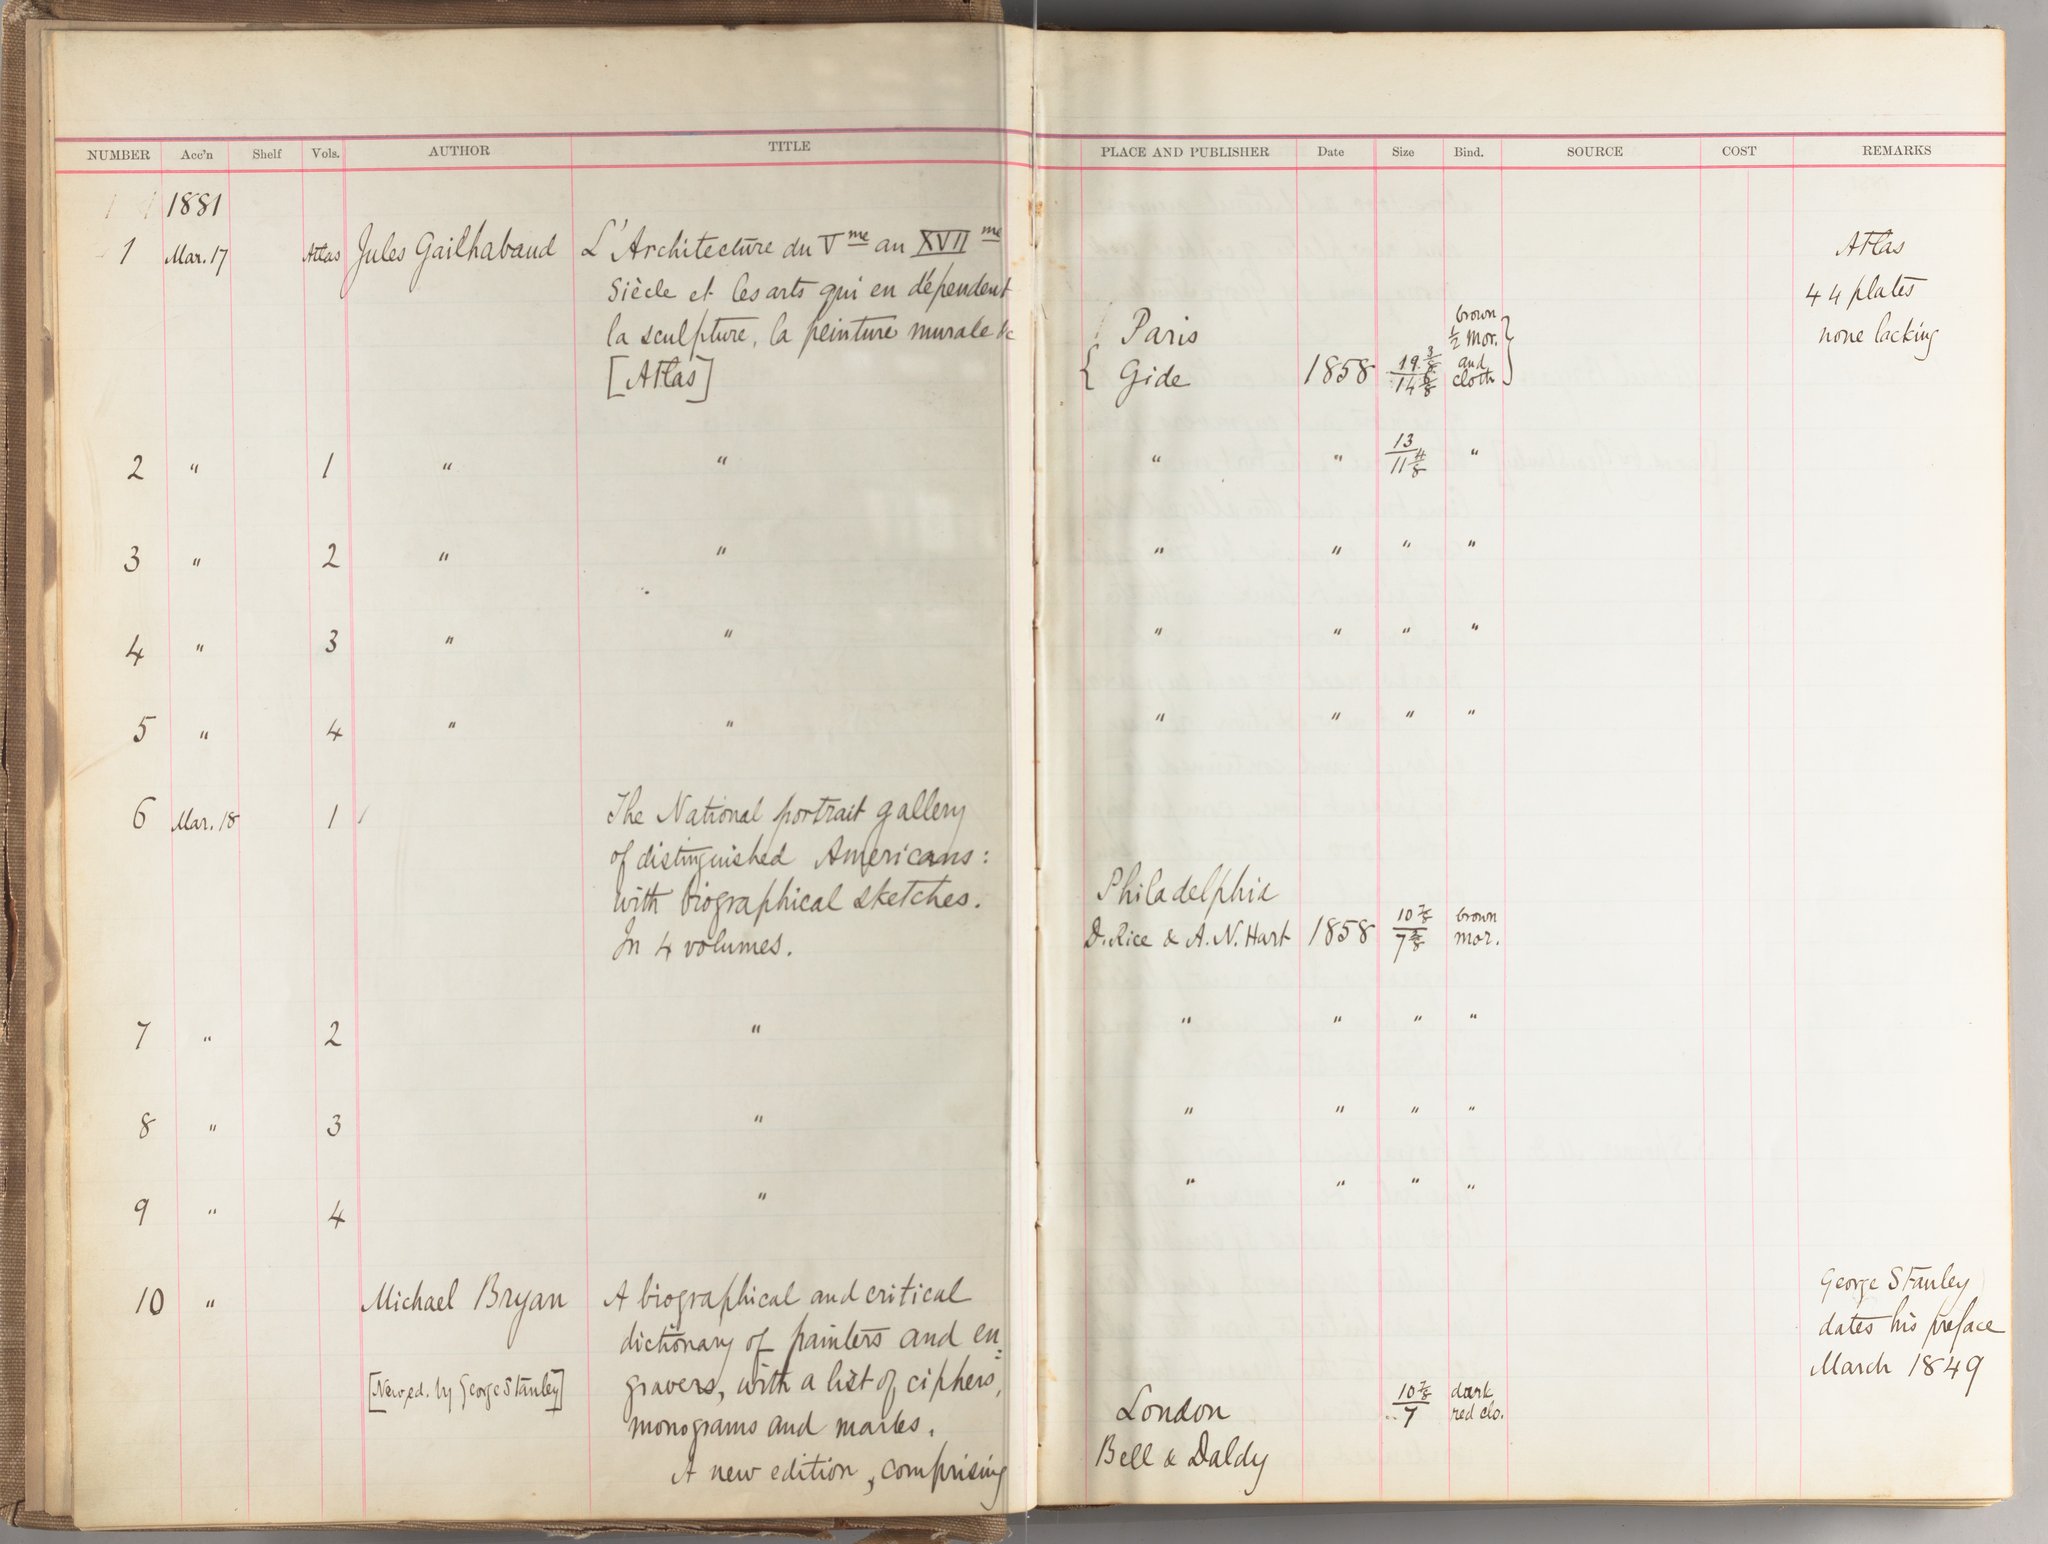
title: Metropolitan Museum of Art Library accession books, 1881-1969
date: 1881-1969